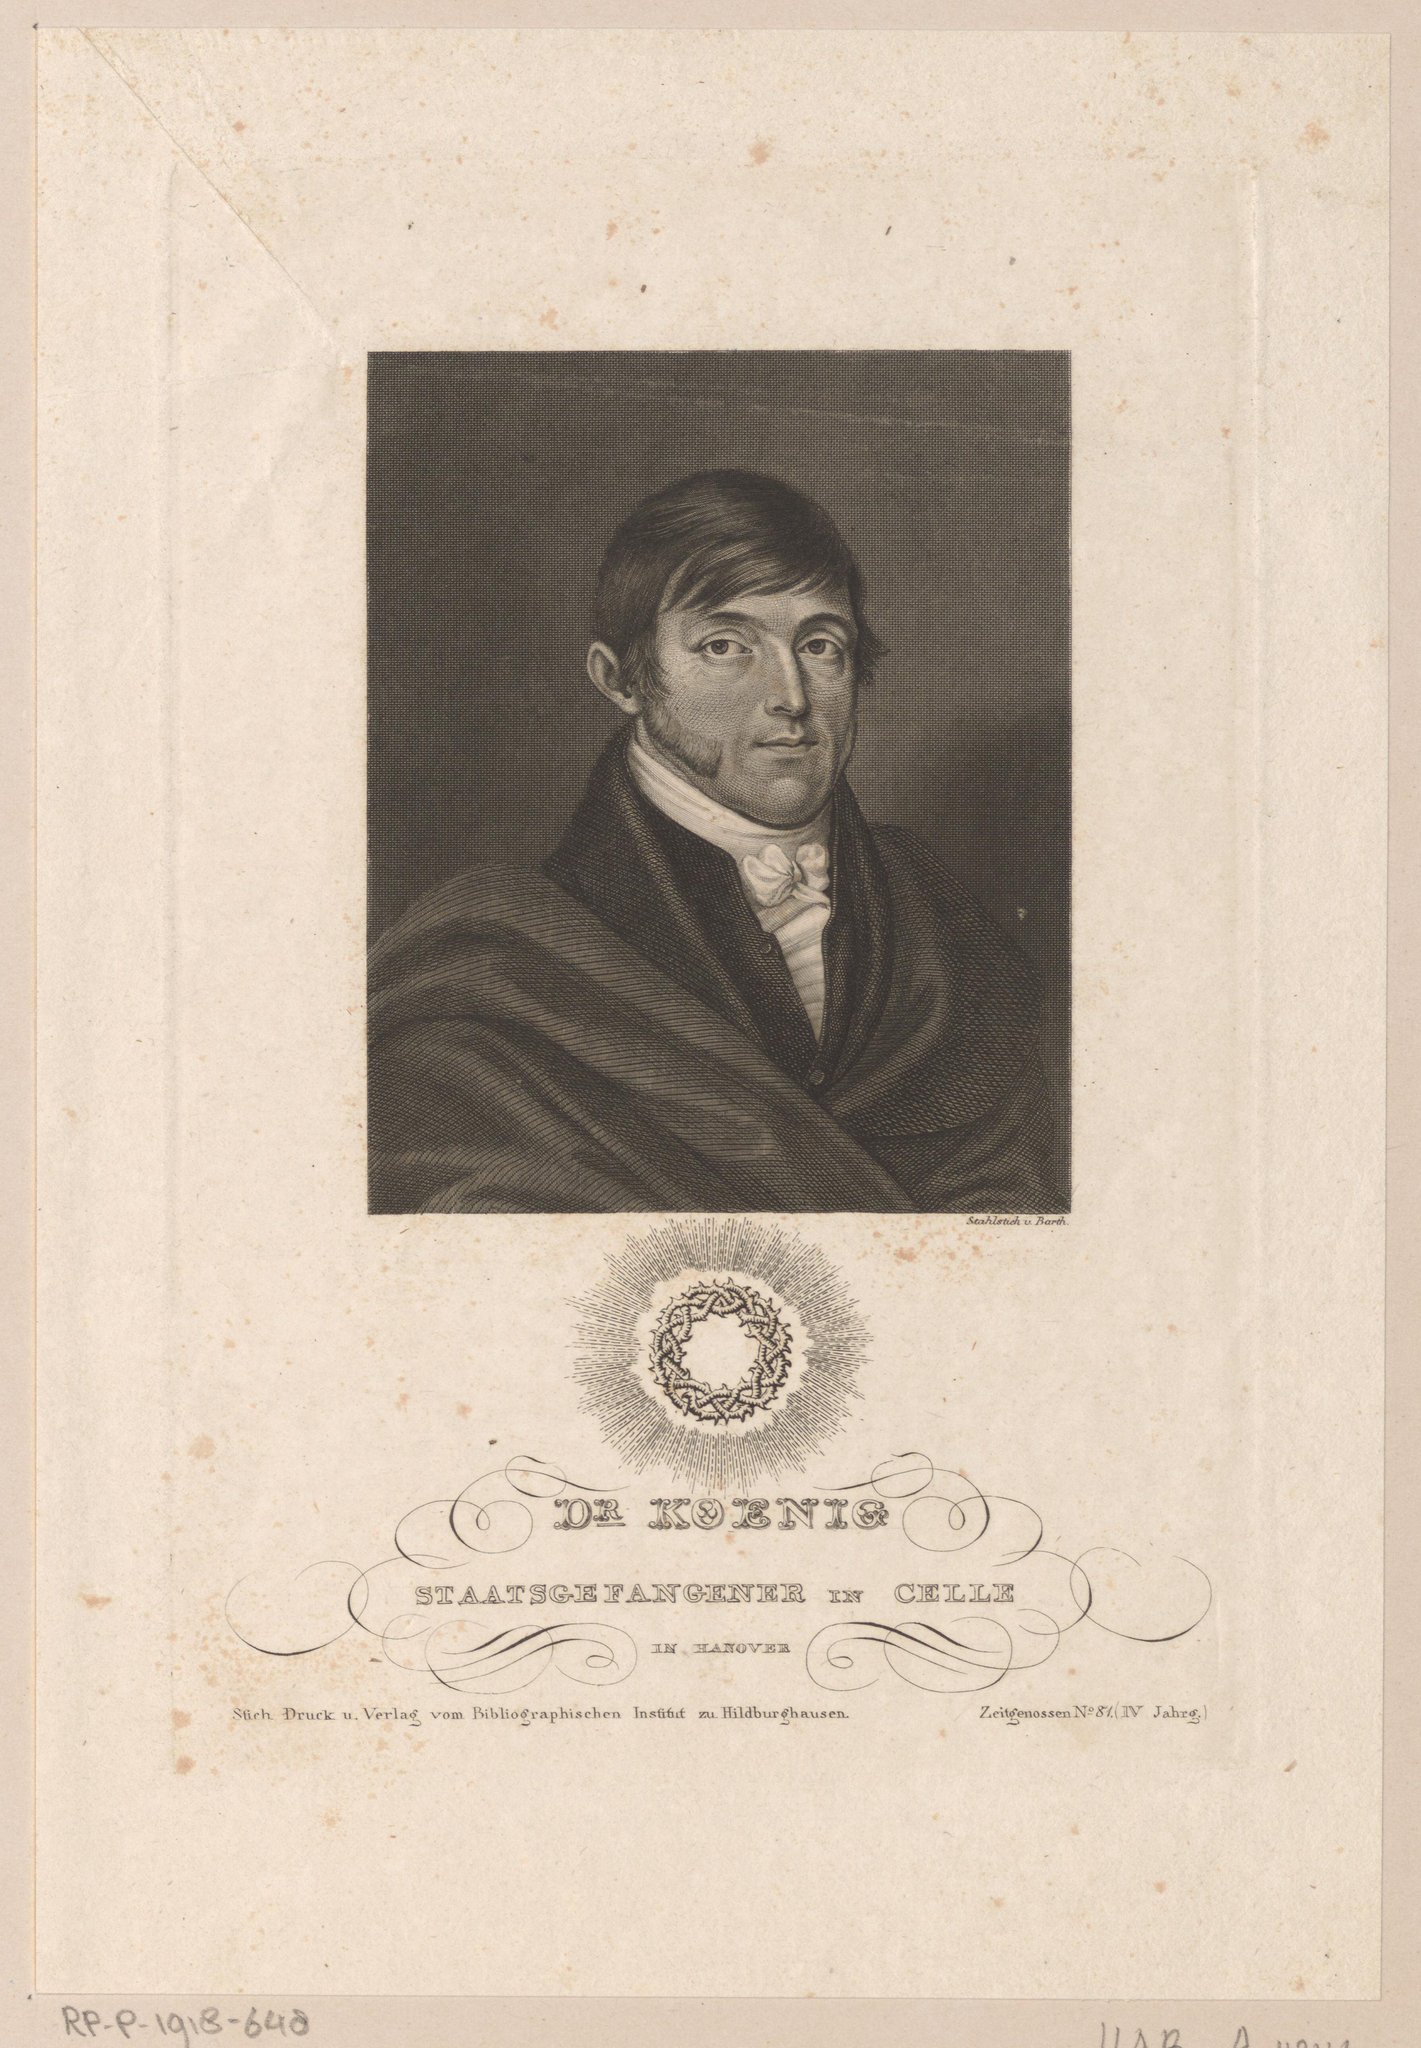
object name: print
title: Tijdgenoten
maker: karl barth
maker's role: print maker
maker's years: 1787-1853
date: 1829-1840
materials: paper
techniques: engraving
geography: hildburghausen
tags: politician, historical persons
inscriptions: collector's mark: Lugt 2233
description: Afkomstig uit de portretserie 'Zeitgenossen', uitgegeven tussen 1829 en circa 1840.